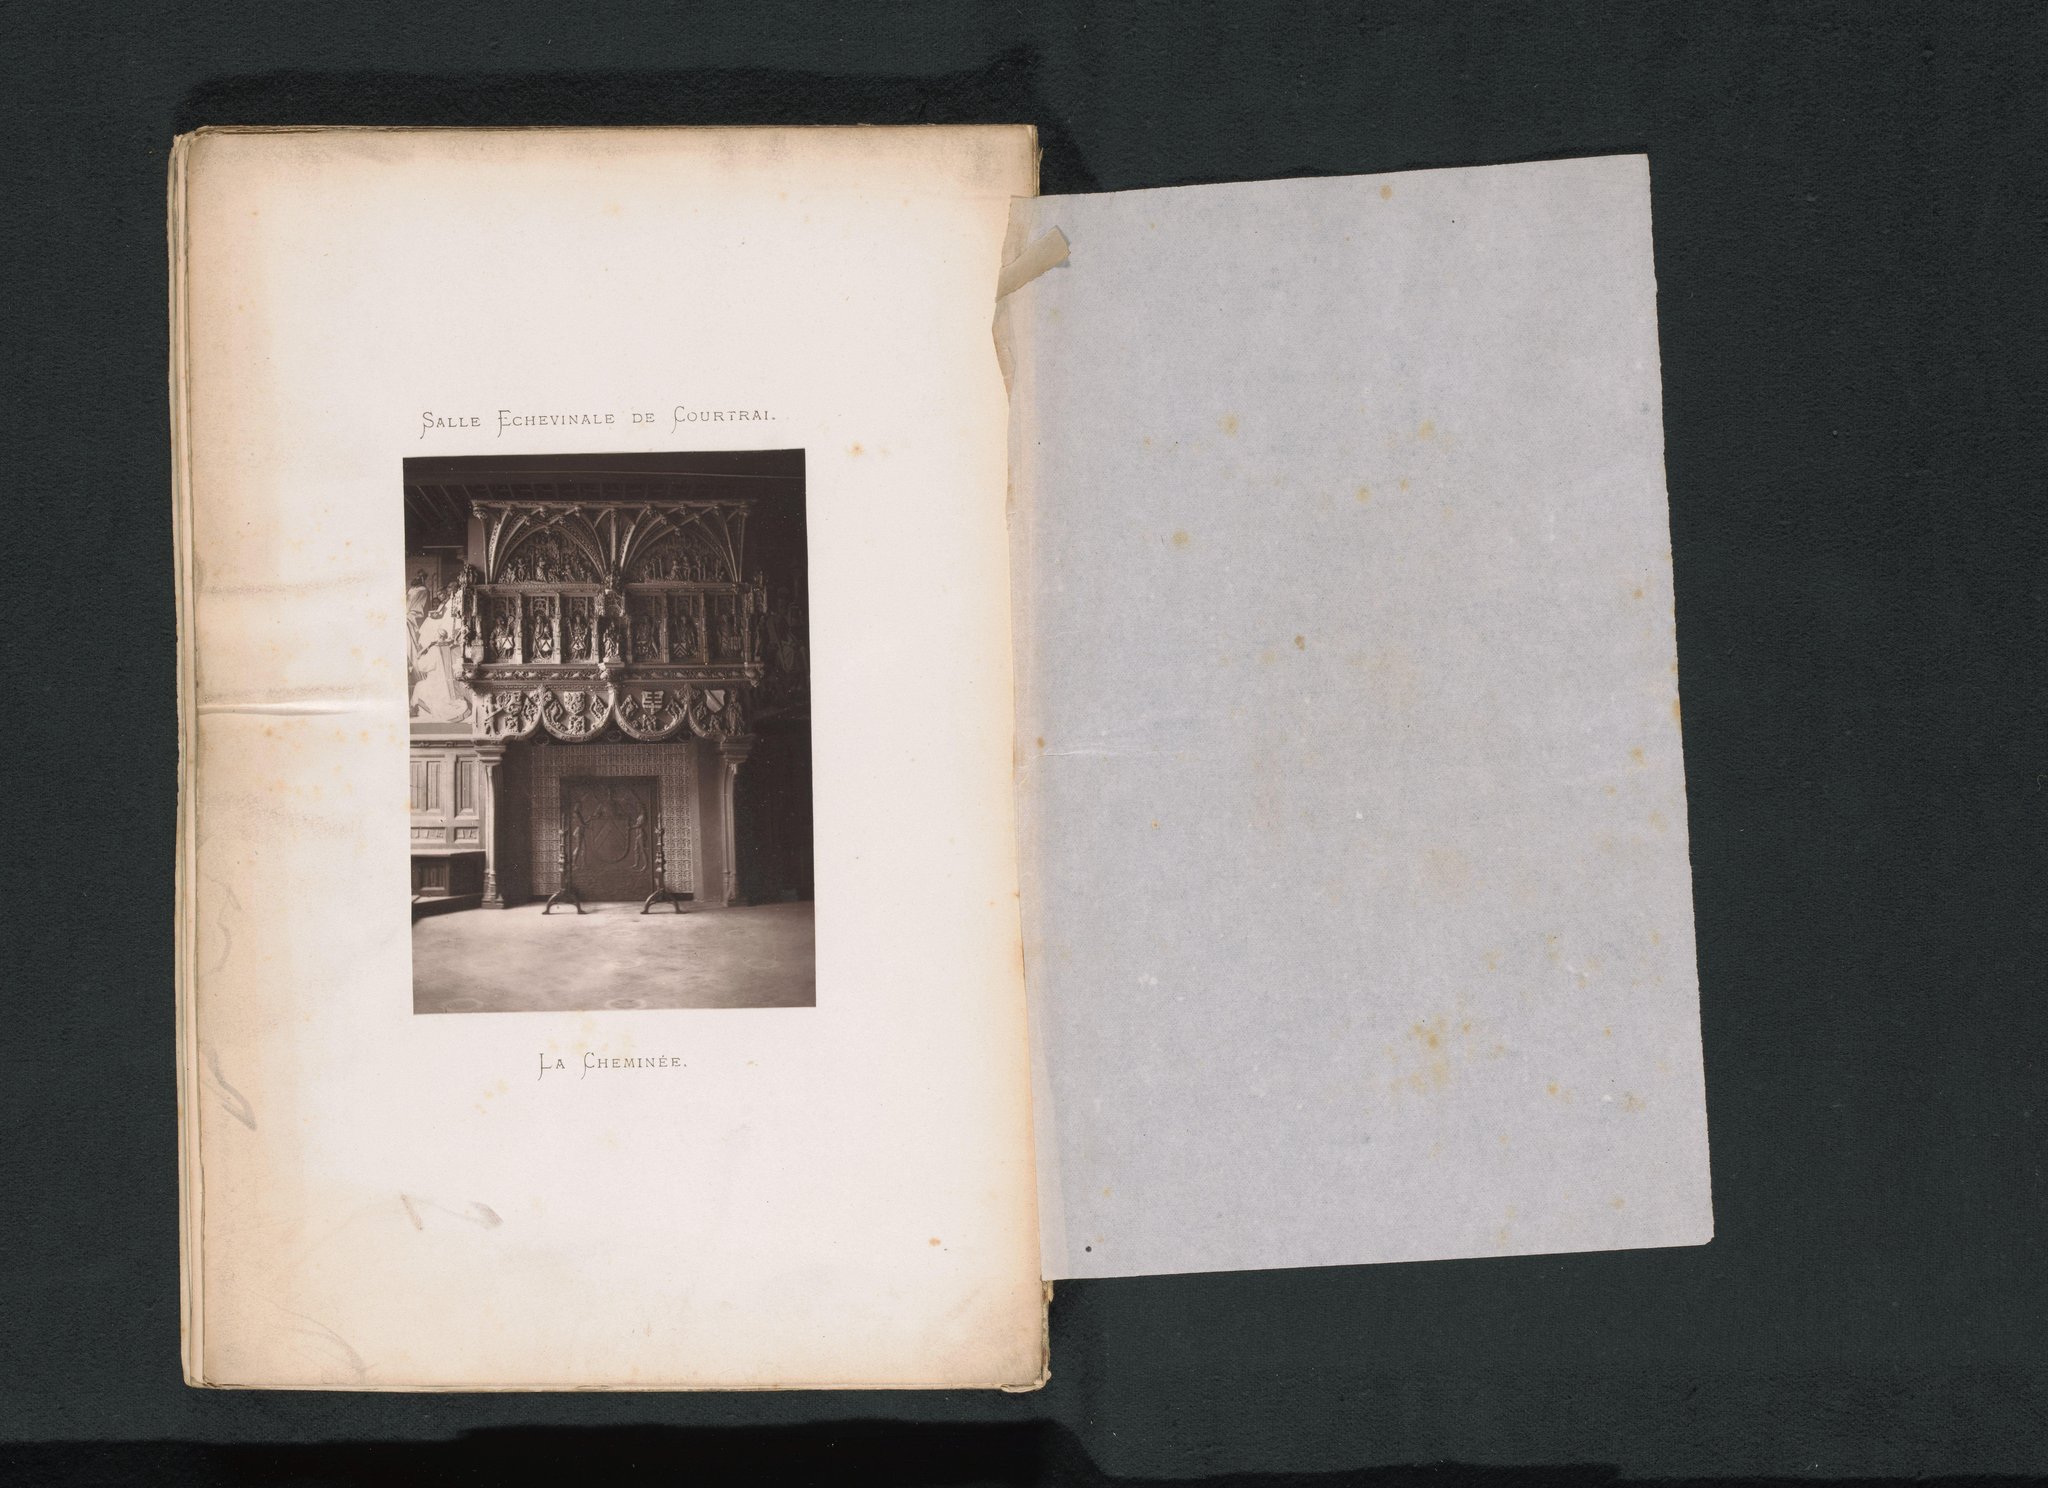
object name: page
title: La Cheminée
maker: Anonymous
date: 1871-1876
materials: paper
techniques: woodburytype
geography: kortrijk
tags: chimney-piece, mantelpiece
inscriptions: inscription: ‘Salle Échevinale de Courtrai.’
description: Prent op laatste pagina van boek. De rest van de pagina's van het boek ontbreekt.